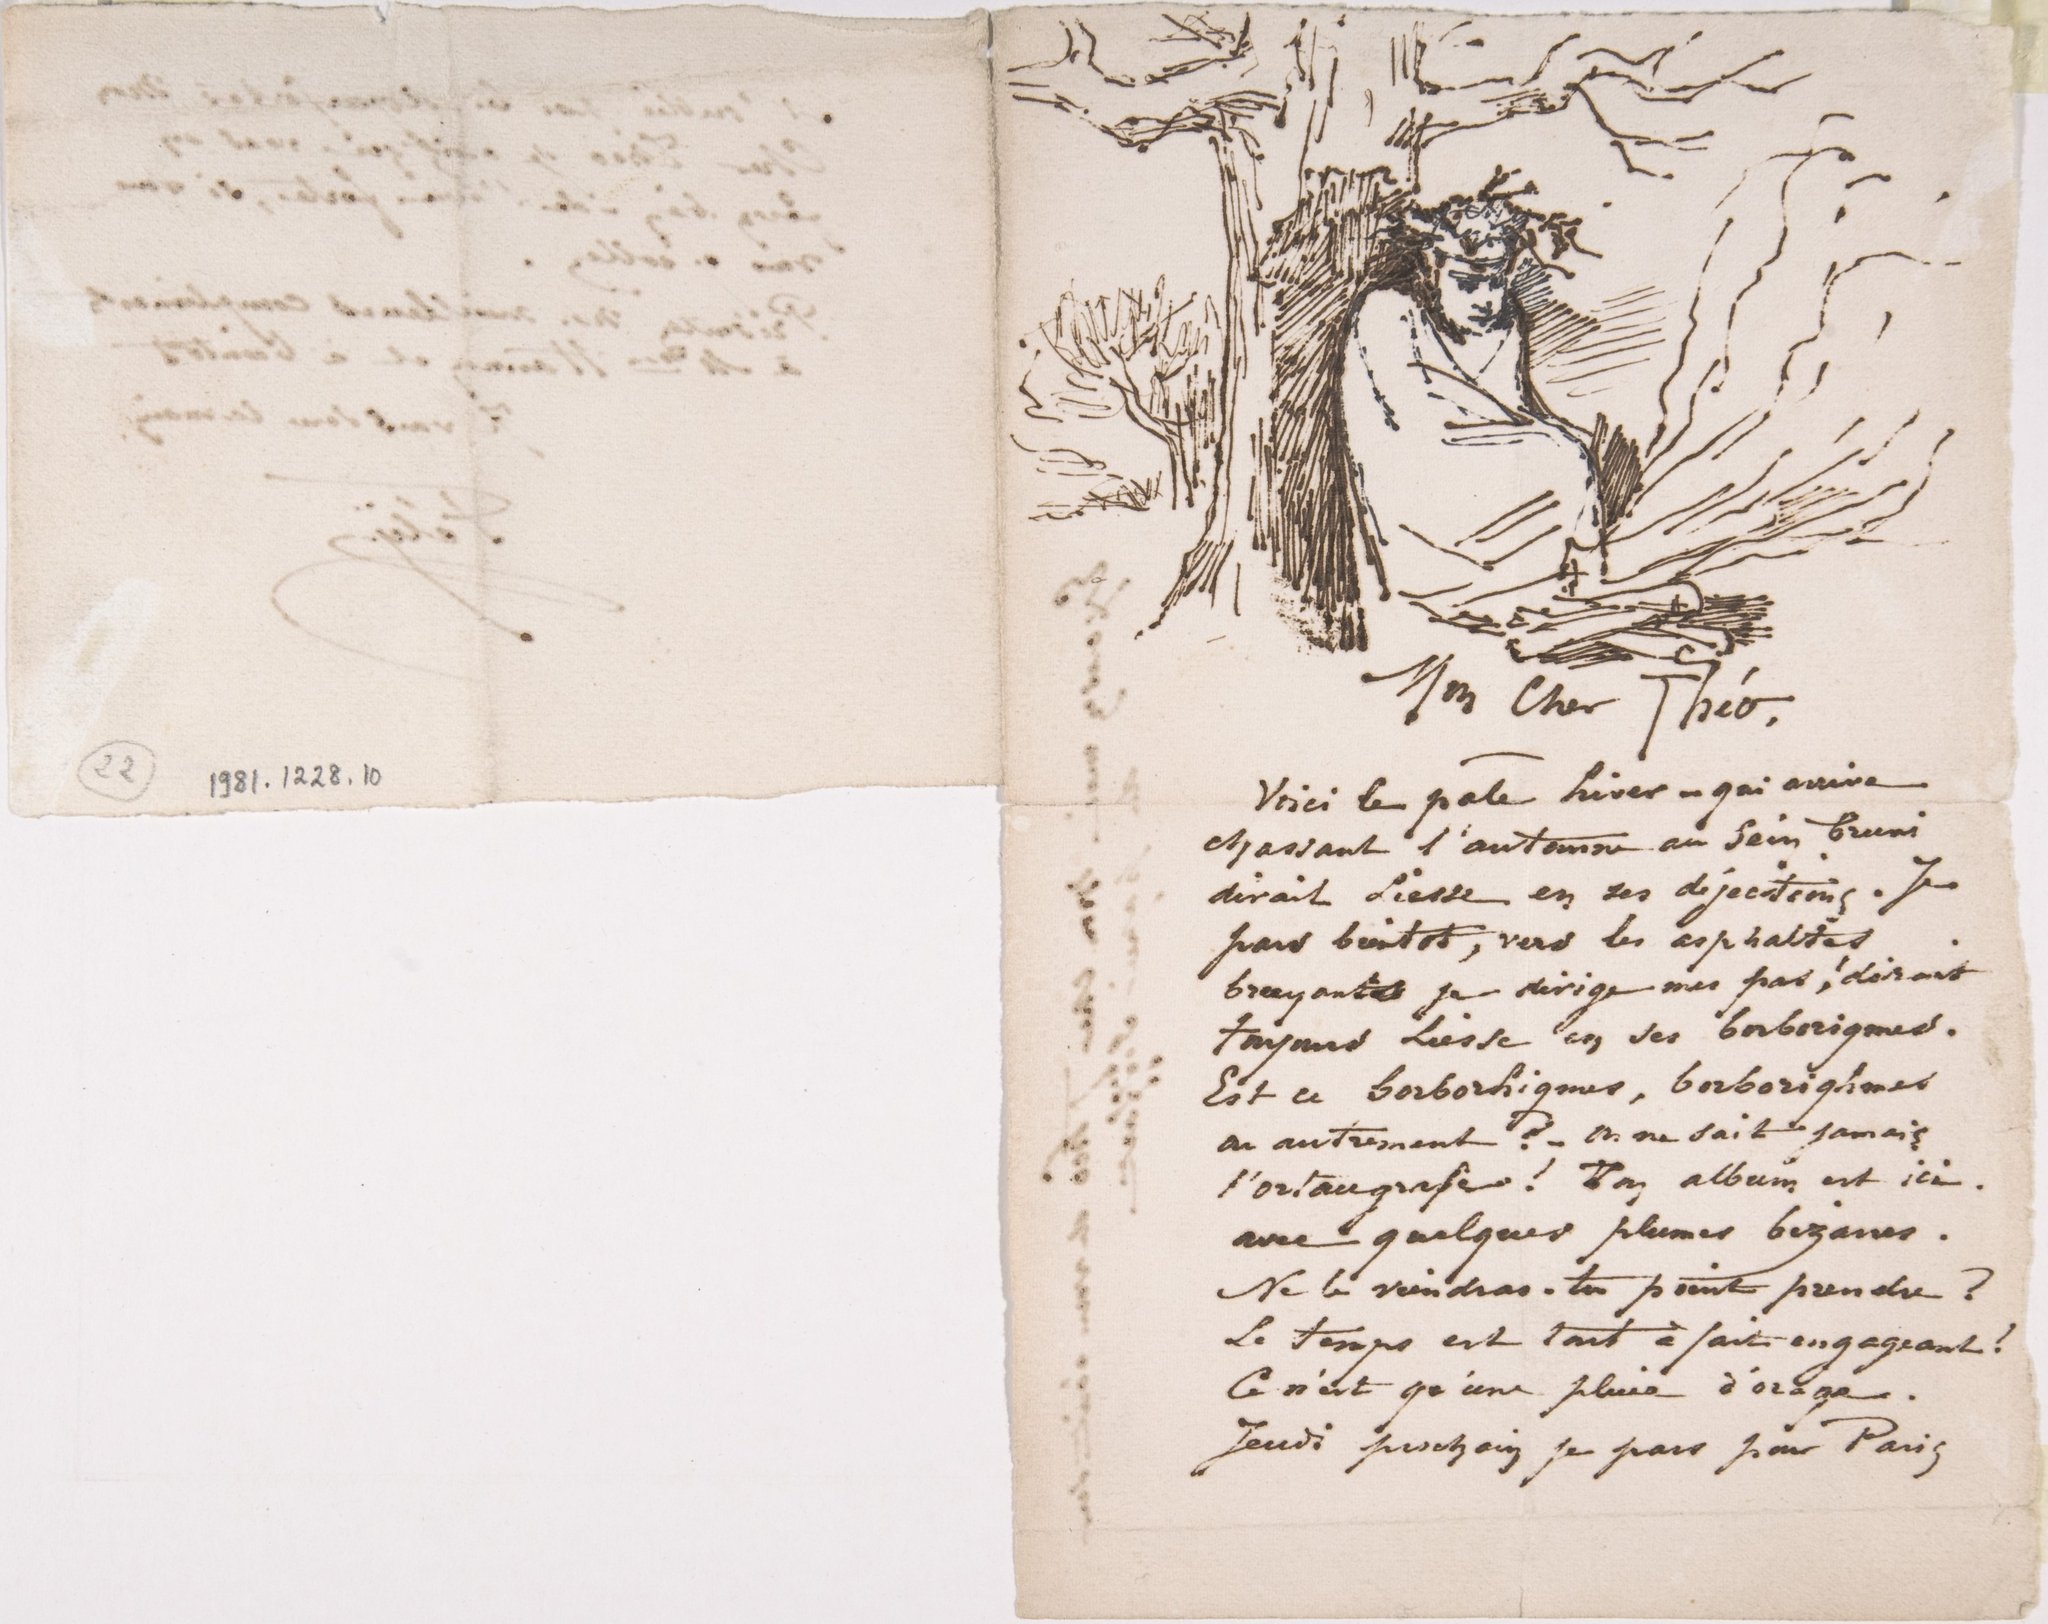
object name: drawing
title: Letter to Theo Hanon, from Rops, signed Fély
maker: félicien rops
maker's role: artist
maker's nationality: belgian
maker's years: 1833-1898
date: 1833-1898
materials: ink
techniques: pen